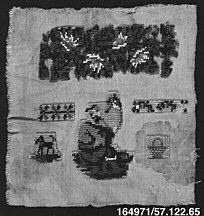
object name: sampler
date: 1801-1900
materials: linen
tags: animals